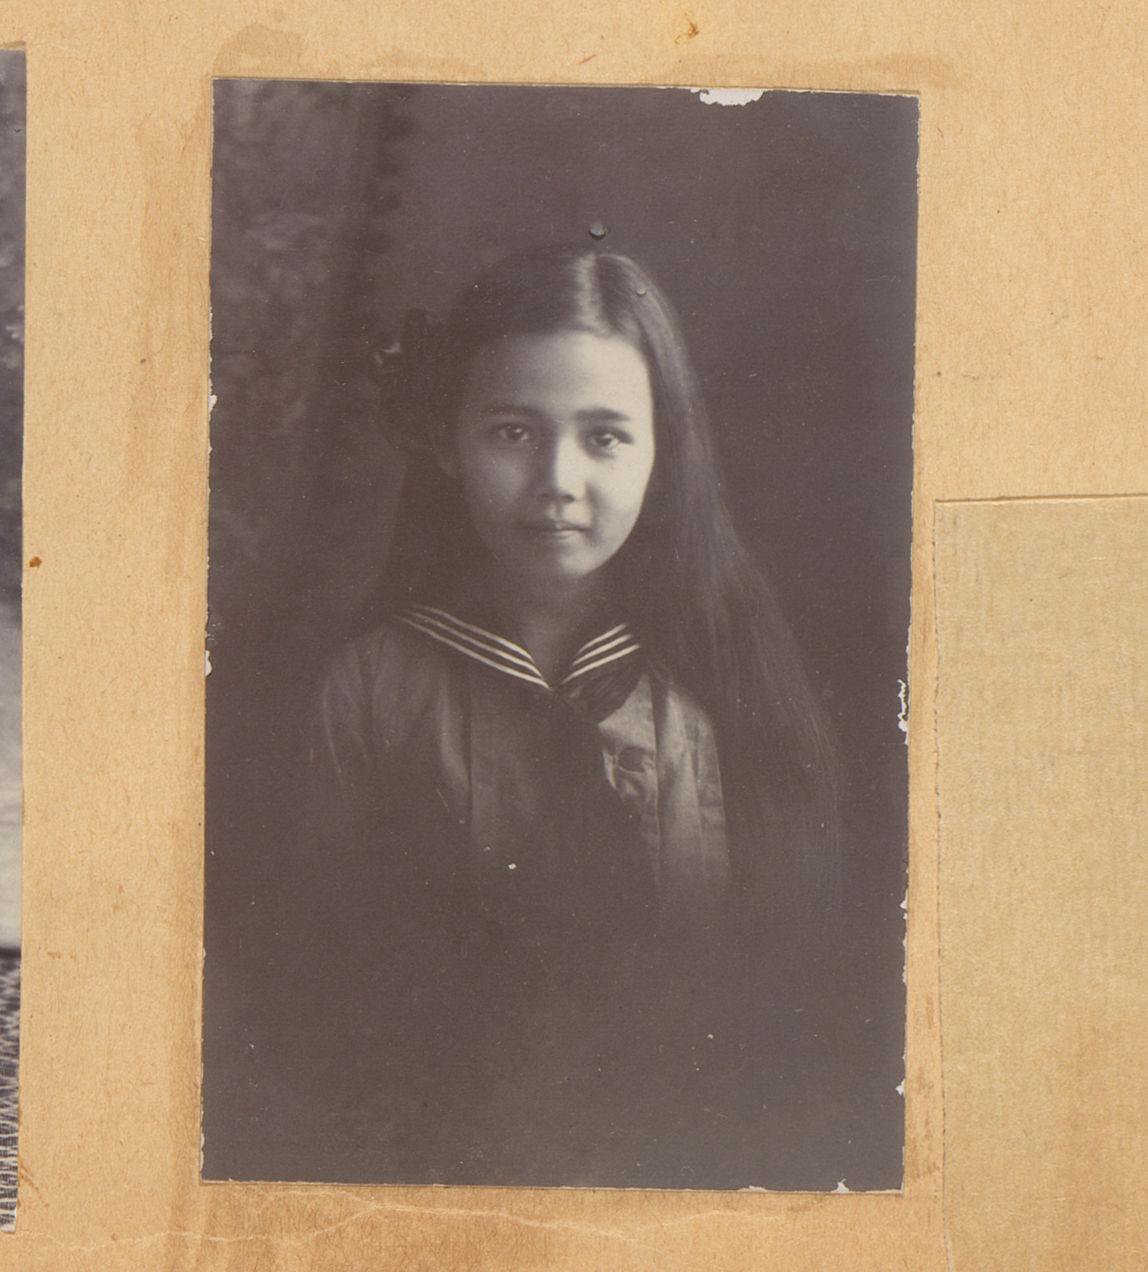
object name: photograph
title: Portret van een jong meisje met lang los haar, vermoedelijk in Nederlands-Indië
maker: Anonymous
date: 1917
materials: photographic support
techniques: gelatin silver print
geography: dutch east indies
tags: child, dutch east indies, the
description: Onderdeel van Familiealbum met foto's van een familie in de voormalige kolonie Nederlands-Indië en van een suikerfabriek in Purworejo.